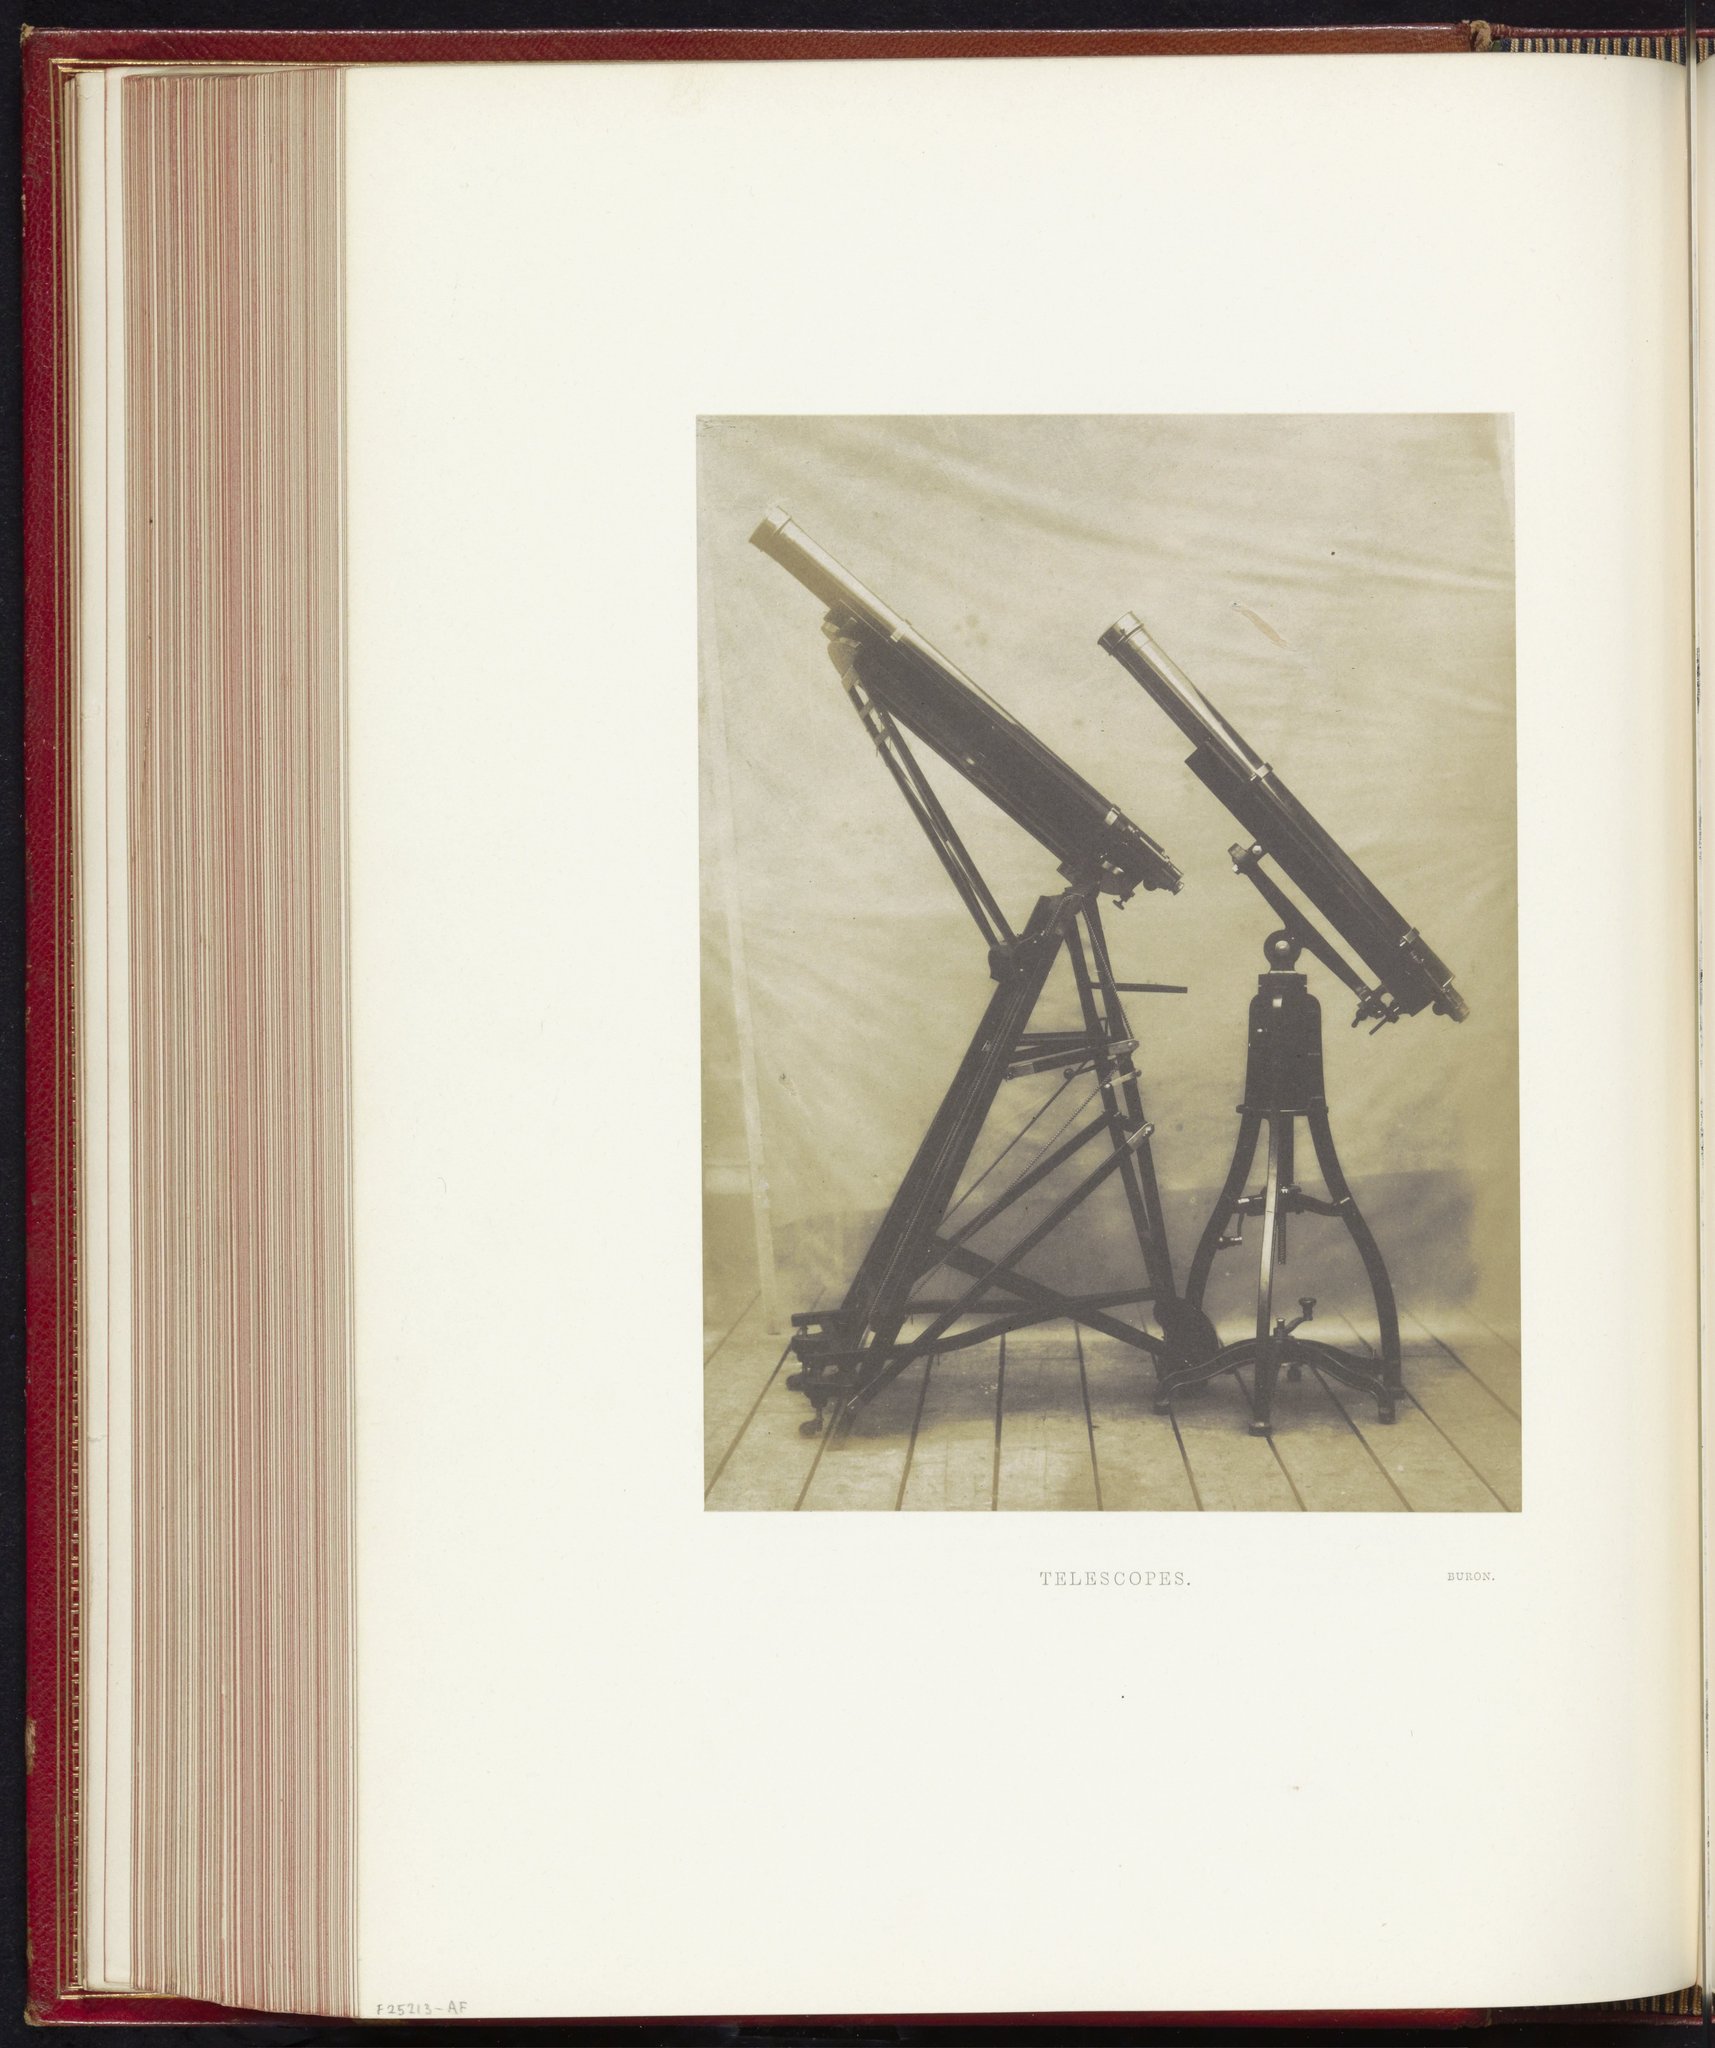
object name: page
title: Telescopen van Buron op de Great Exhibition of the Works of Industry of All Nations van 1851 in Londen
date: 1851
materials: photographic support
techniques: salted paper print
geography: london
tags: telescope, london